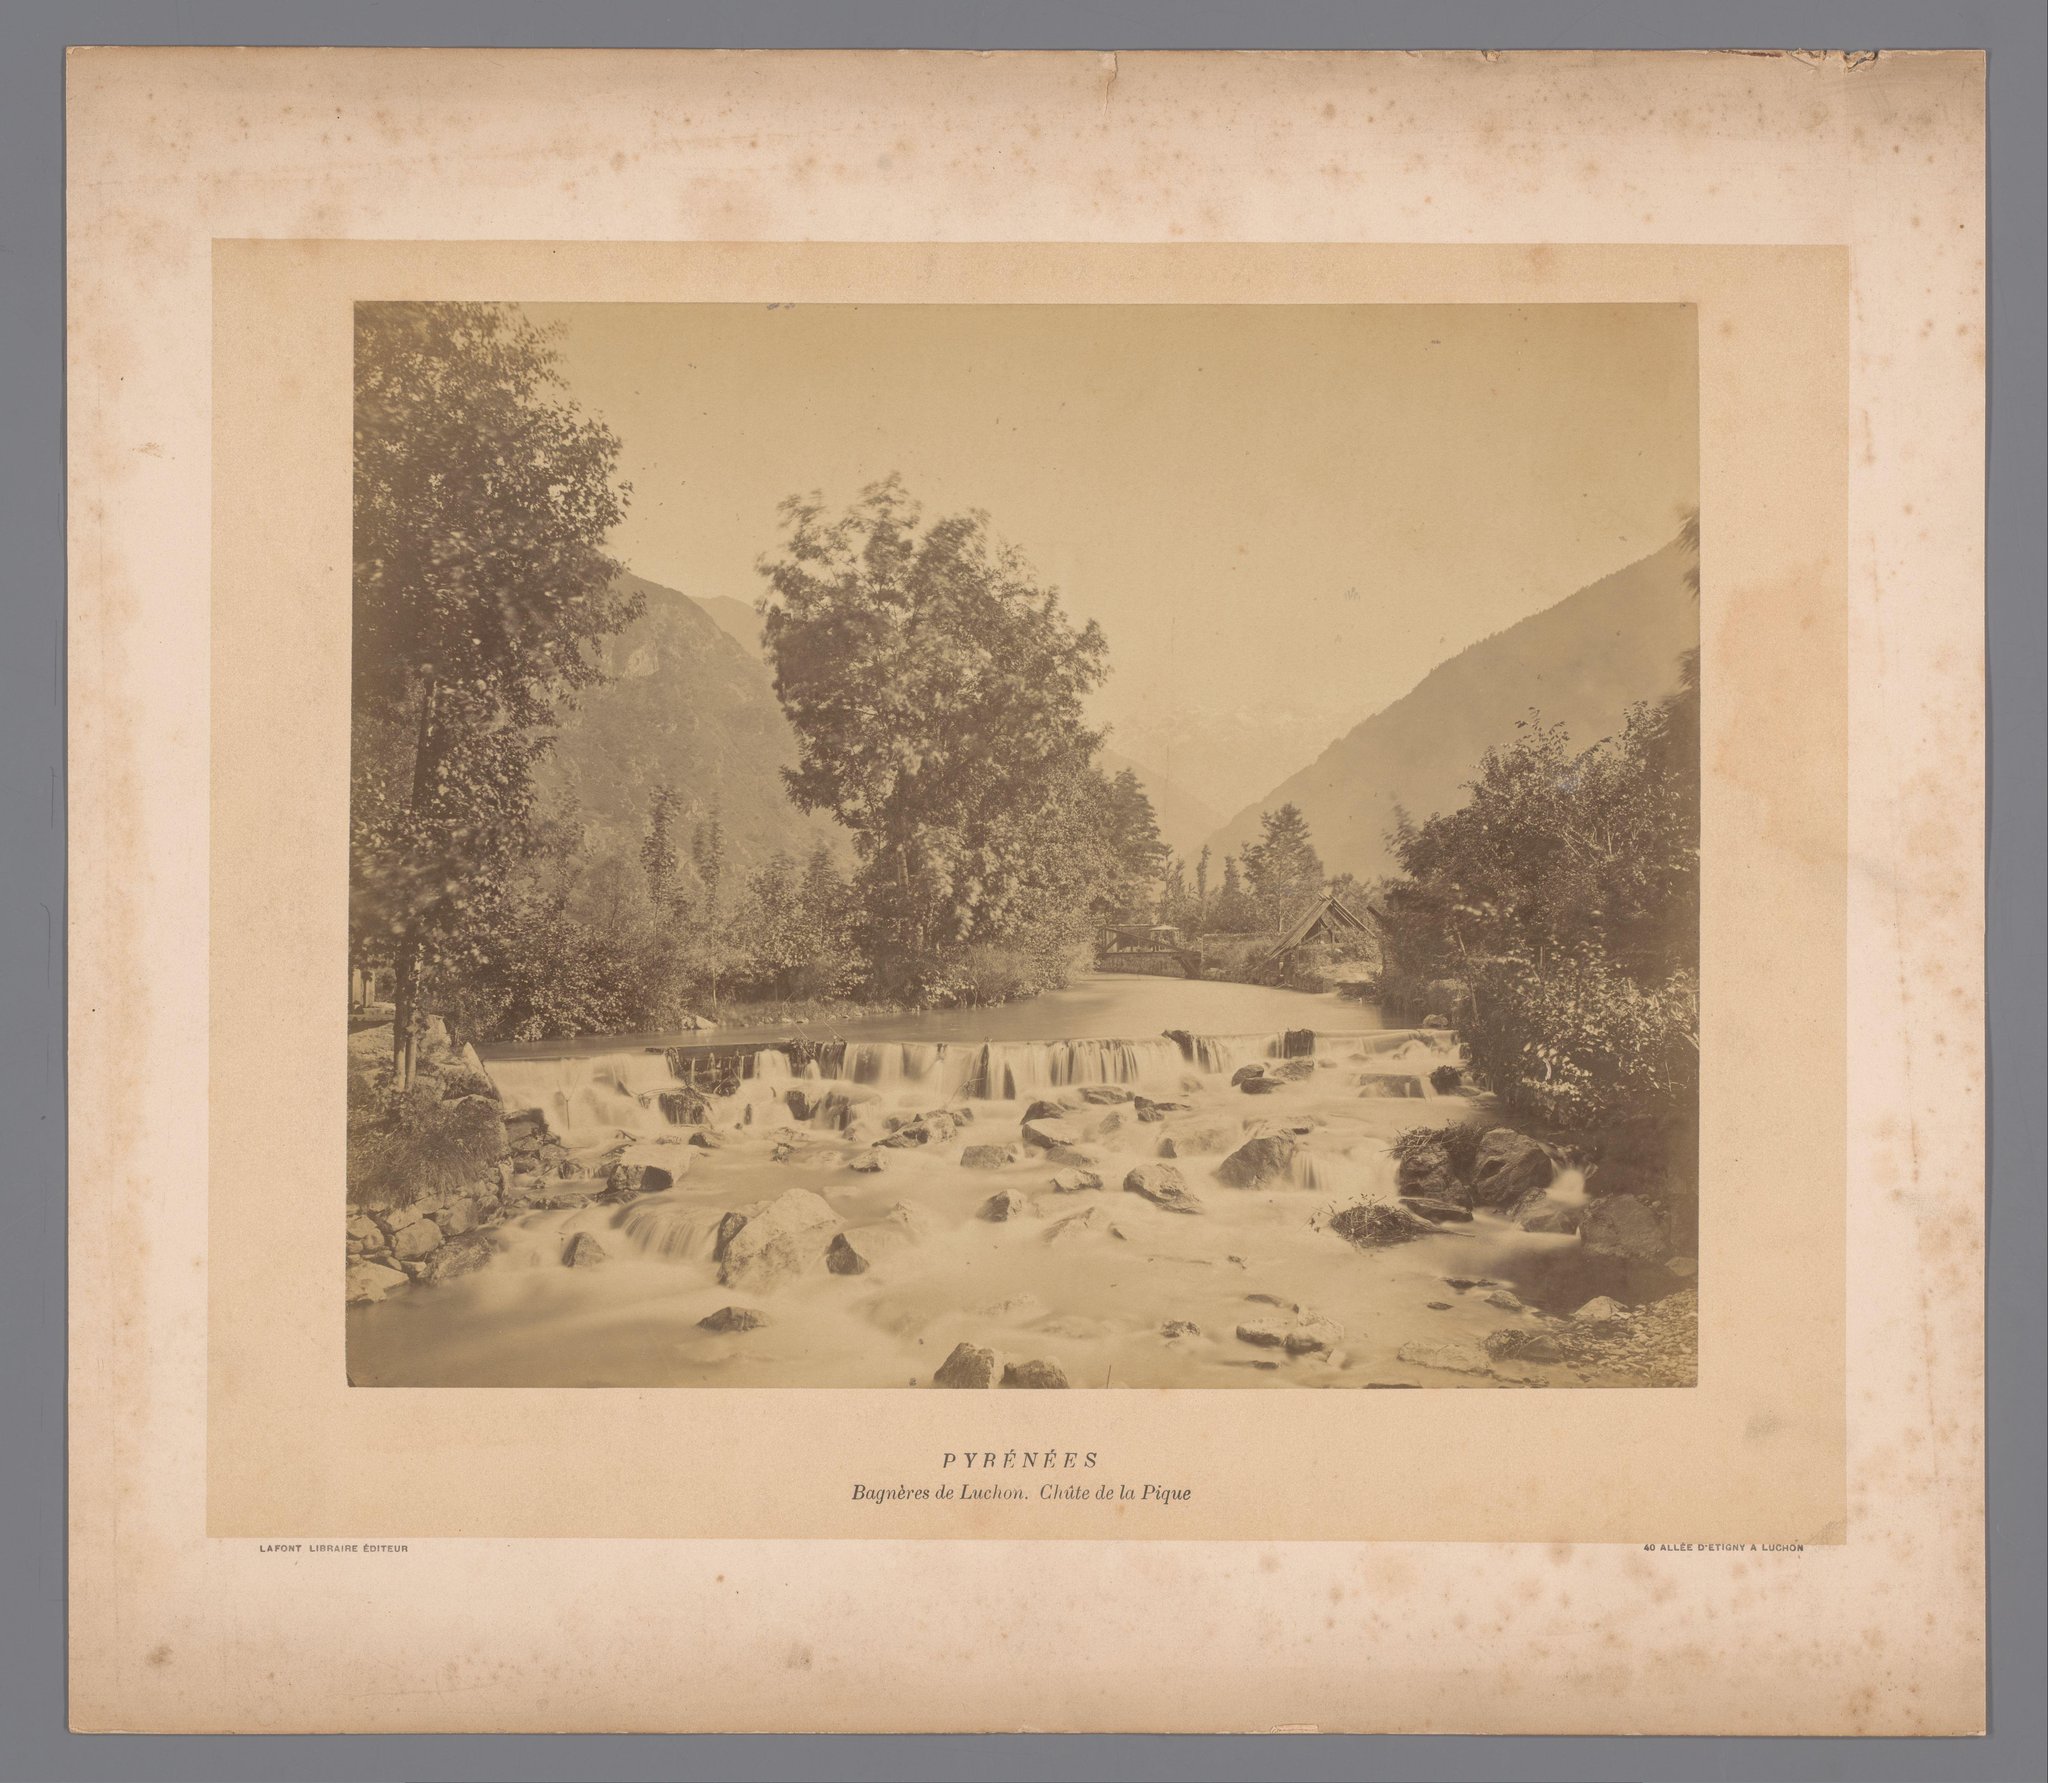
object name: photograph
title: "PYRÉNÉES//Bagnères de Luchon. Chûte de la Pique", Frankrijk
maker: Anonymous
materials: cardboard, paper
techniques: albumen print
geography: luchon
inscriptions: caption: ‘LAFONT LIBRAIRE ÉDITEUR//40 ALLÉE D'ETIGNY A LUCHON’, caption: ‘PYRÉNÉES//Bagnères de Luchon. Chûte de la Pique’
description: Frontaal aanzicht op een rivier met lage waterval, Frankrijk.